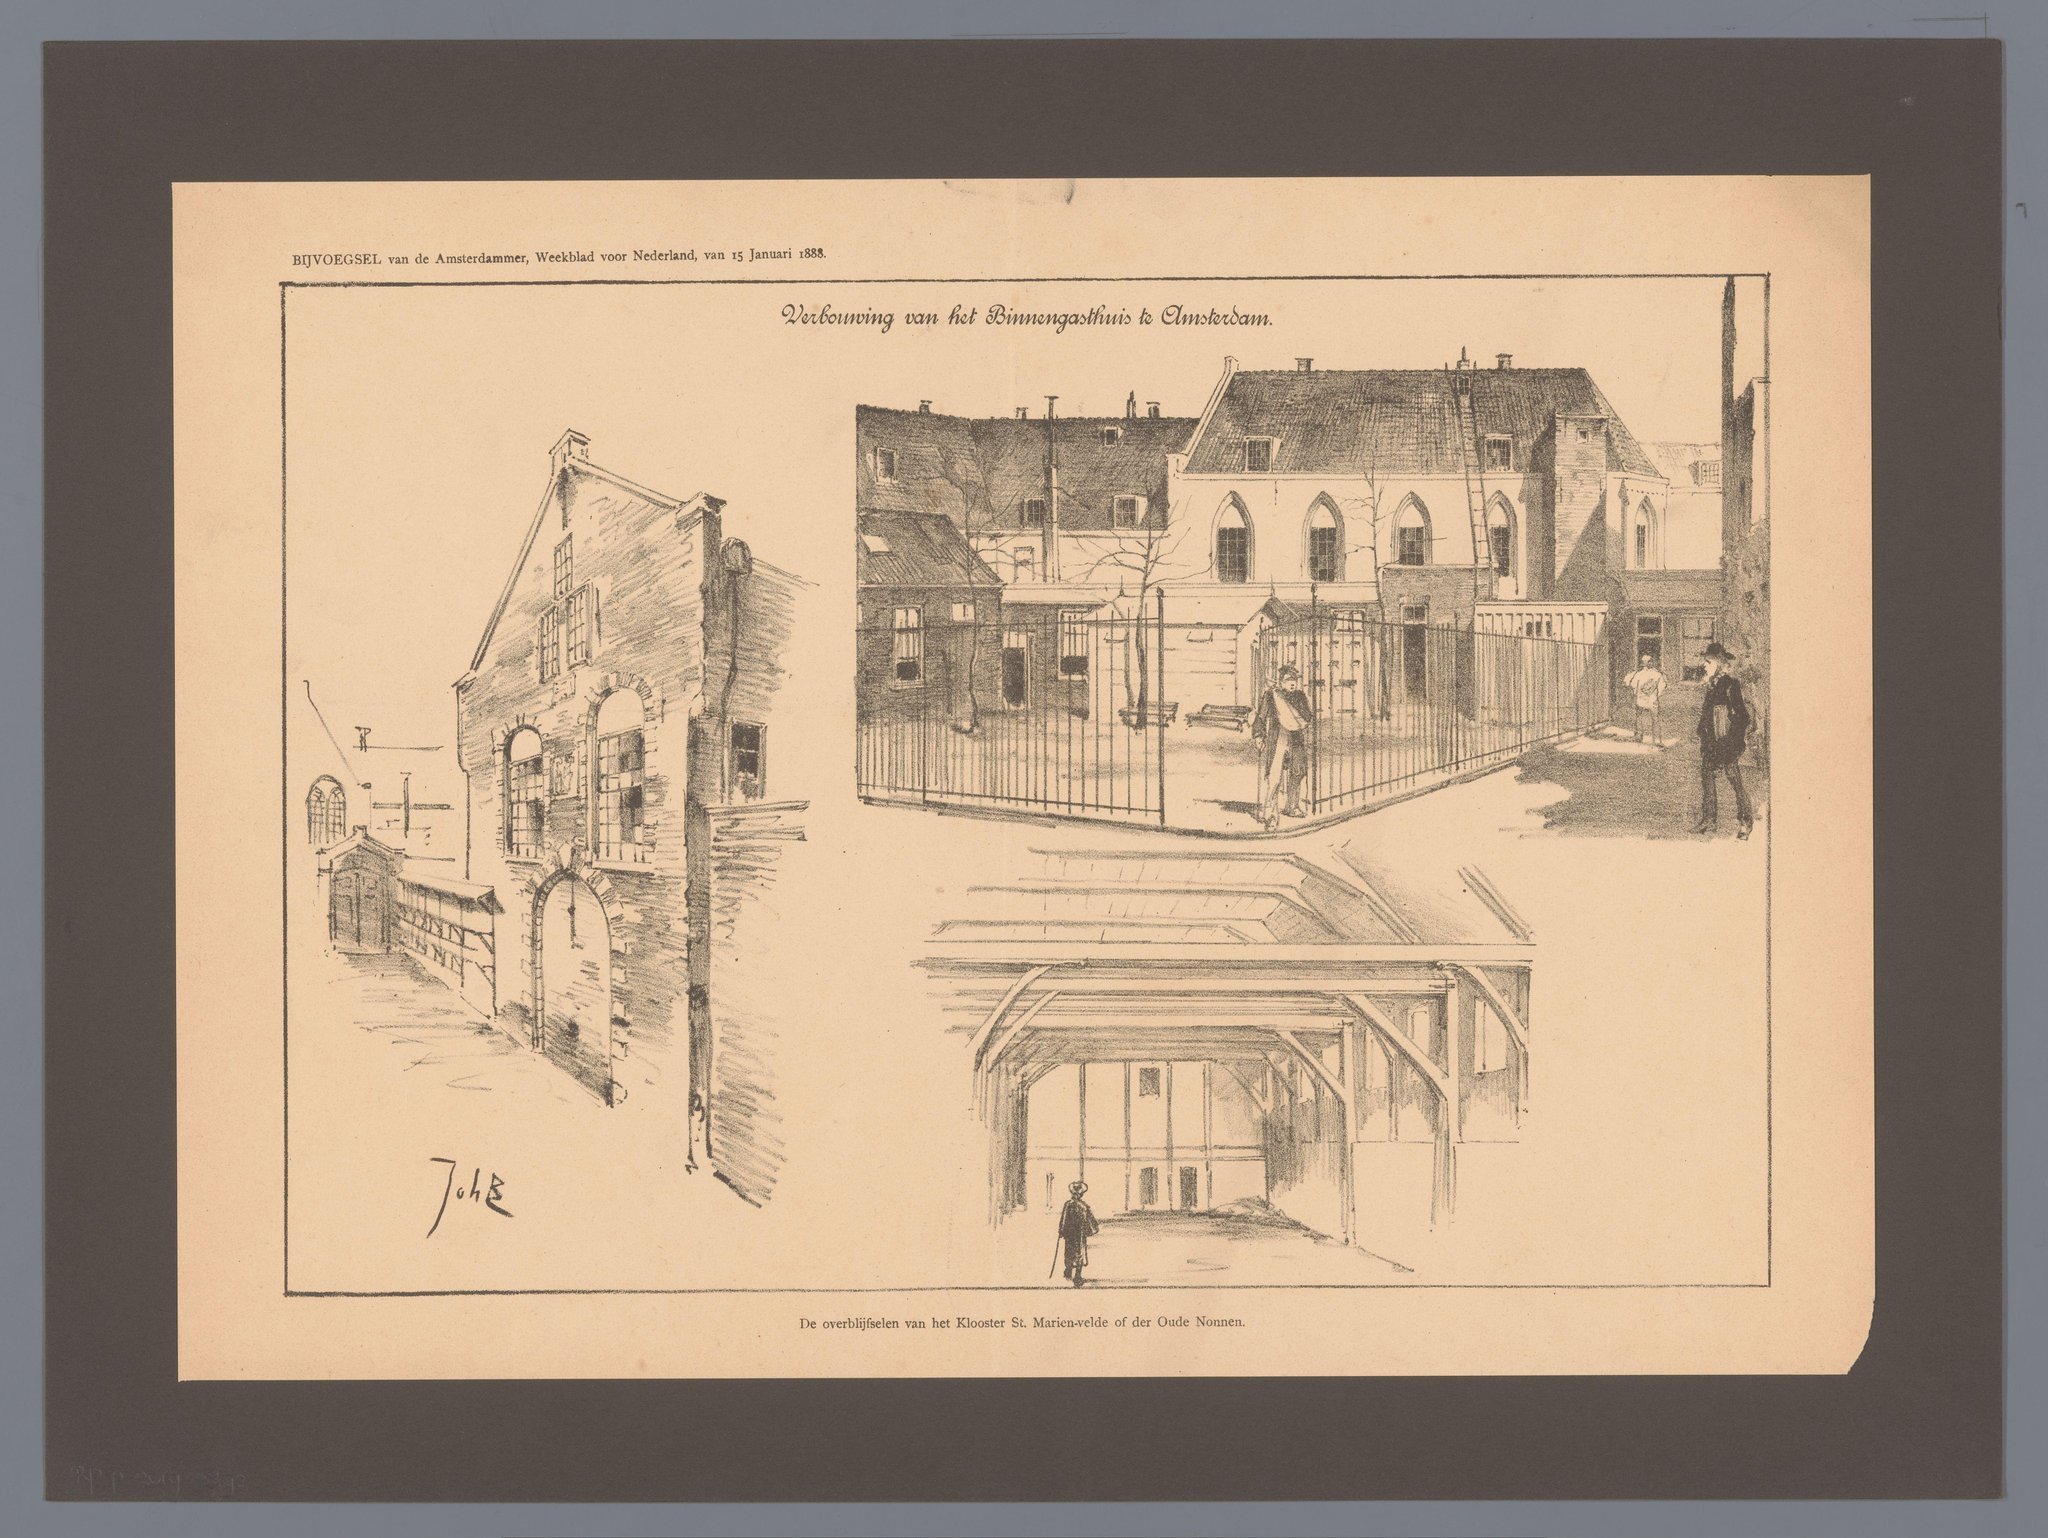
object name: book illustration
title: Gezichten op het Binnengasthuis in Amsterdam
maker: johan braakensiek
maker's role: draughtsman, print maker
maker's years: 1858-1940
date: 1888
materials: paper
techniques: lithograph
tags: hospital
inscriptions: date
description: Prent uit: De Amsterdammer, Weekblad voor Nederland (1888), 15 januari 1888.